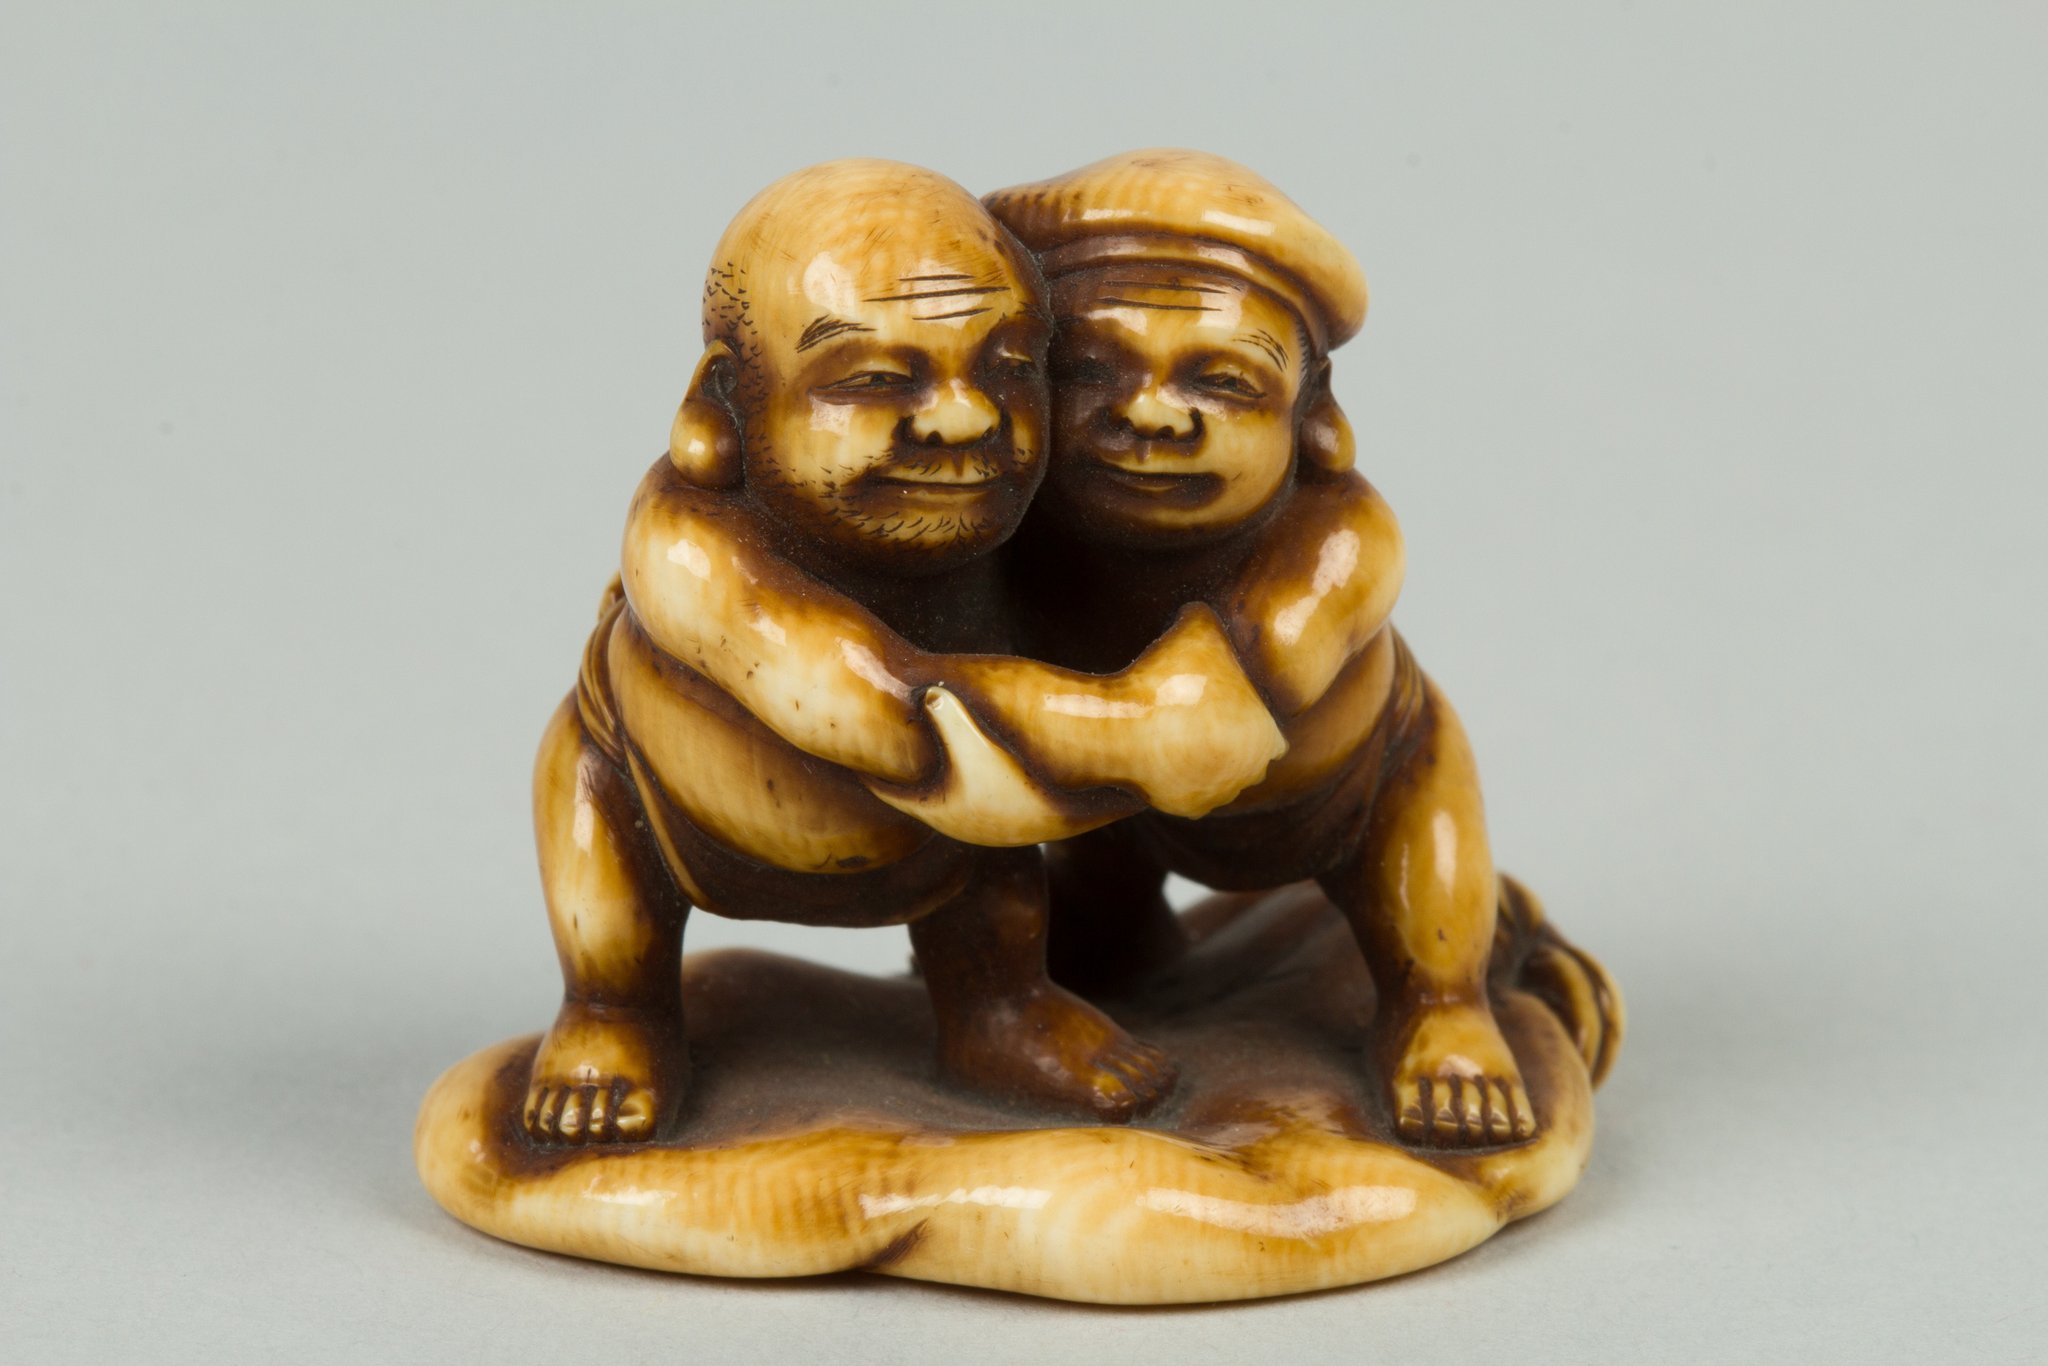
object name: netsuke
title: Netsuke of Daikoku and Fukurokuji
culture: japanese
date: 1801-1900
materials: ivory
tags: men